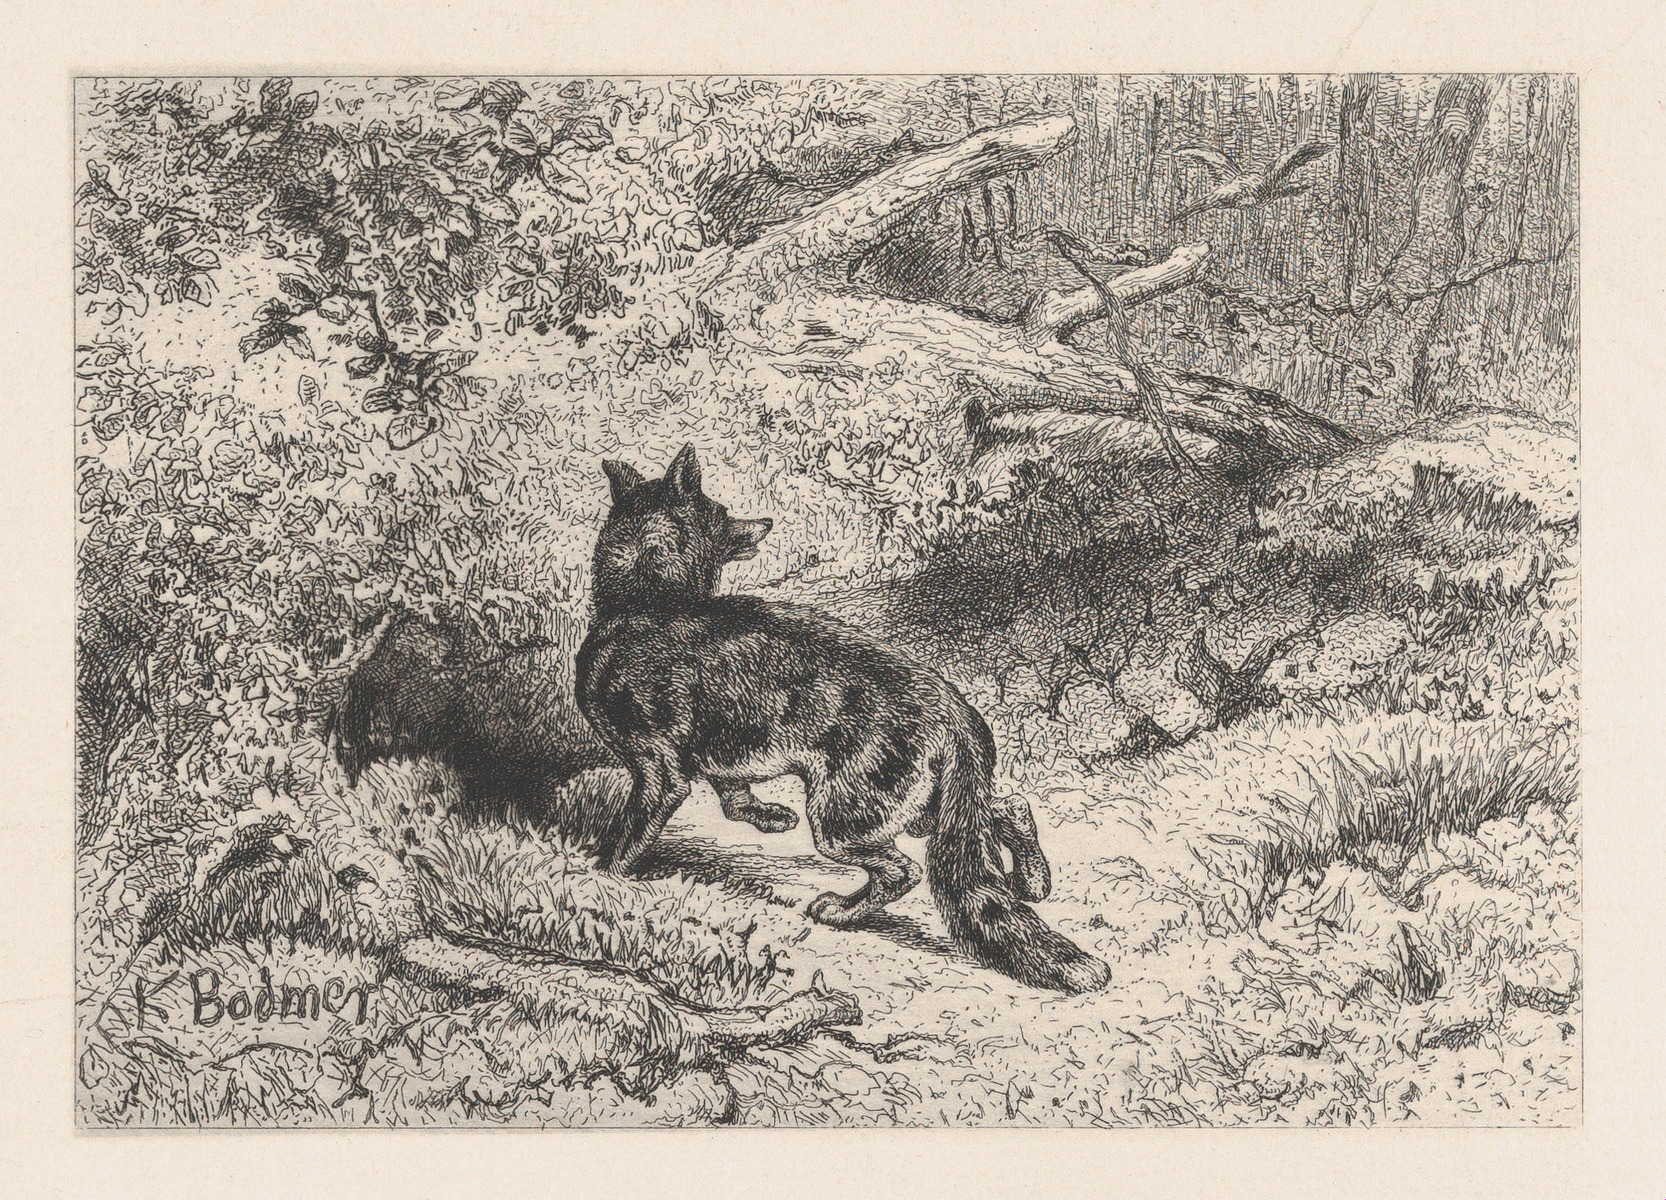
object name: print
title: A Fox, from "Eaux-Fortes Animaux & Paysages"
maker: karl bodmer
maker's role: artist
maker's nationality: swiss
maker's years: 1809-1893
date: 1860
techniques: etching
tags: foxes